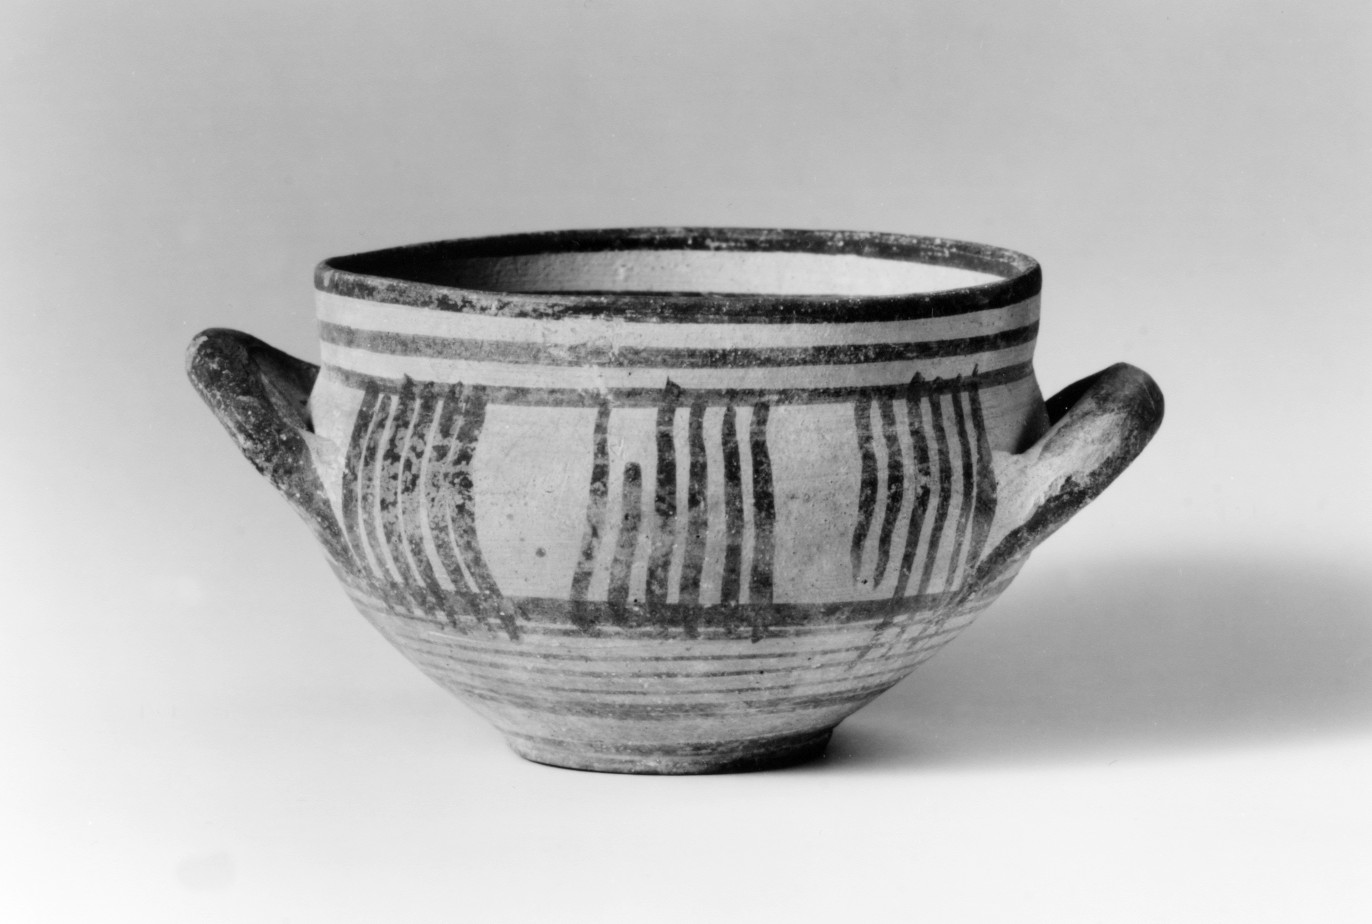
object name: bowl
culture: greek, attic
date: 800 BCE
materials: terracotta